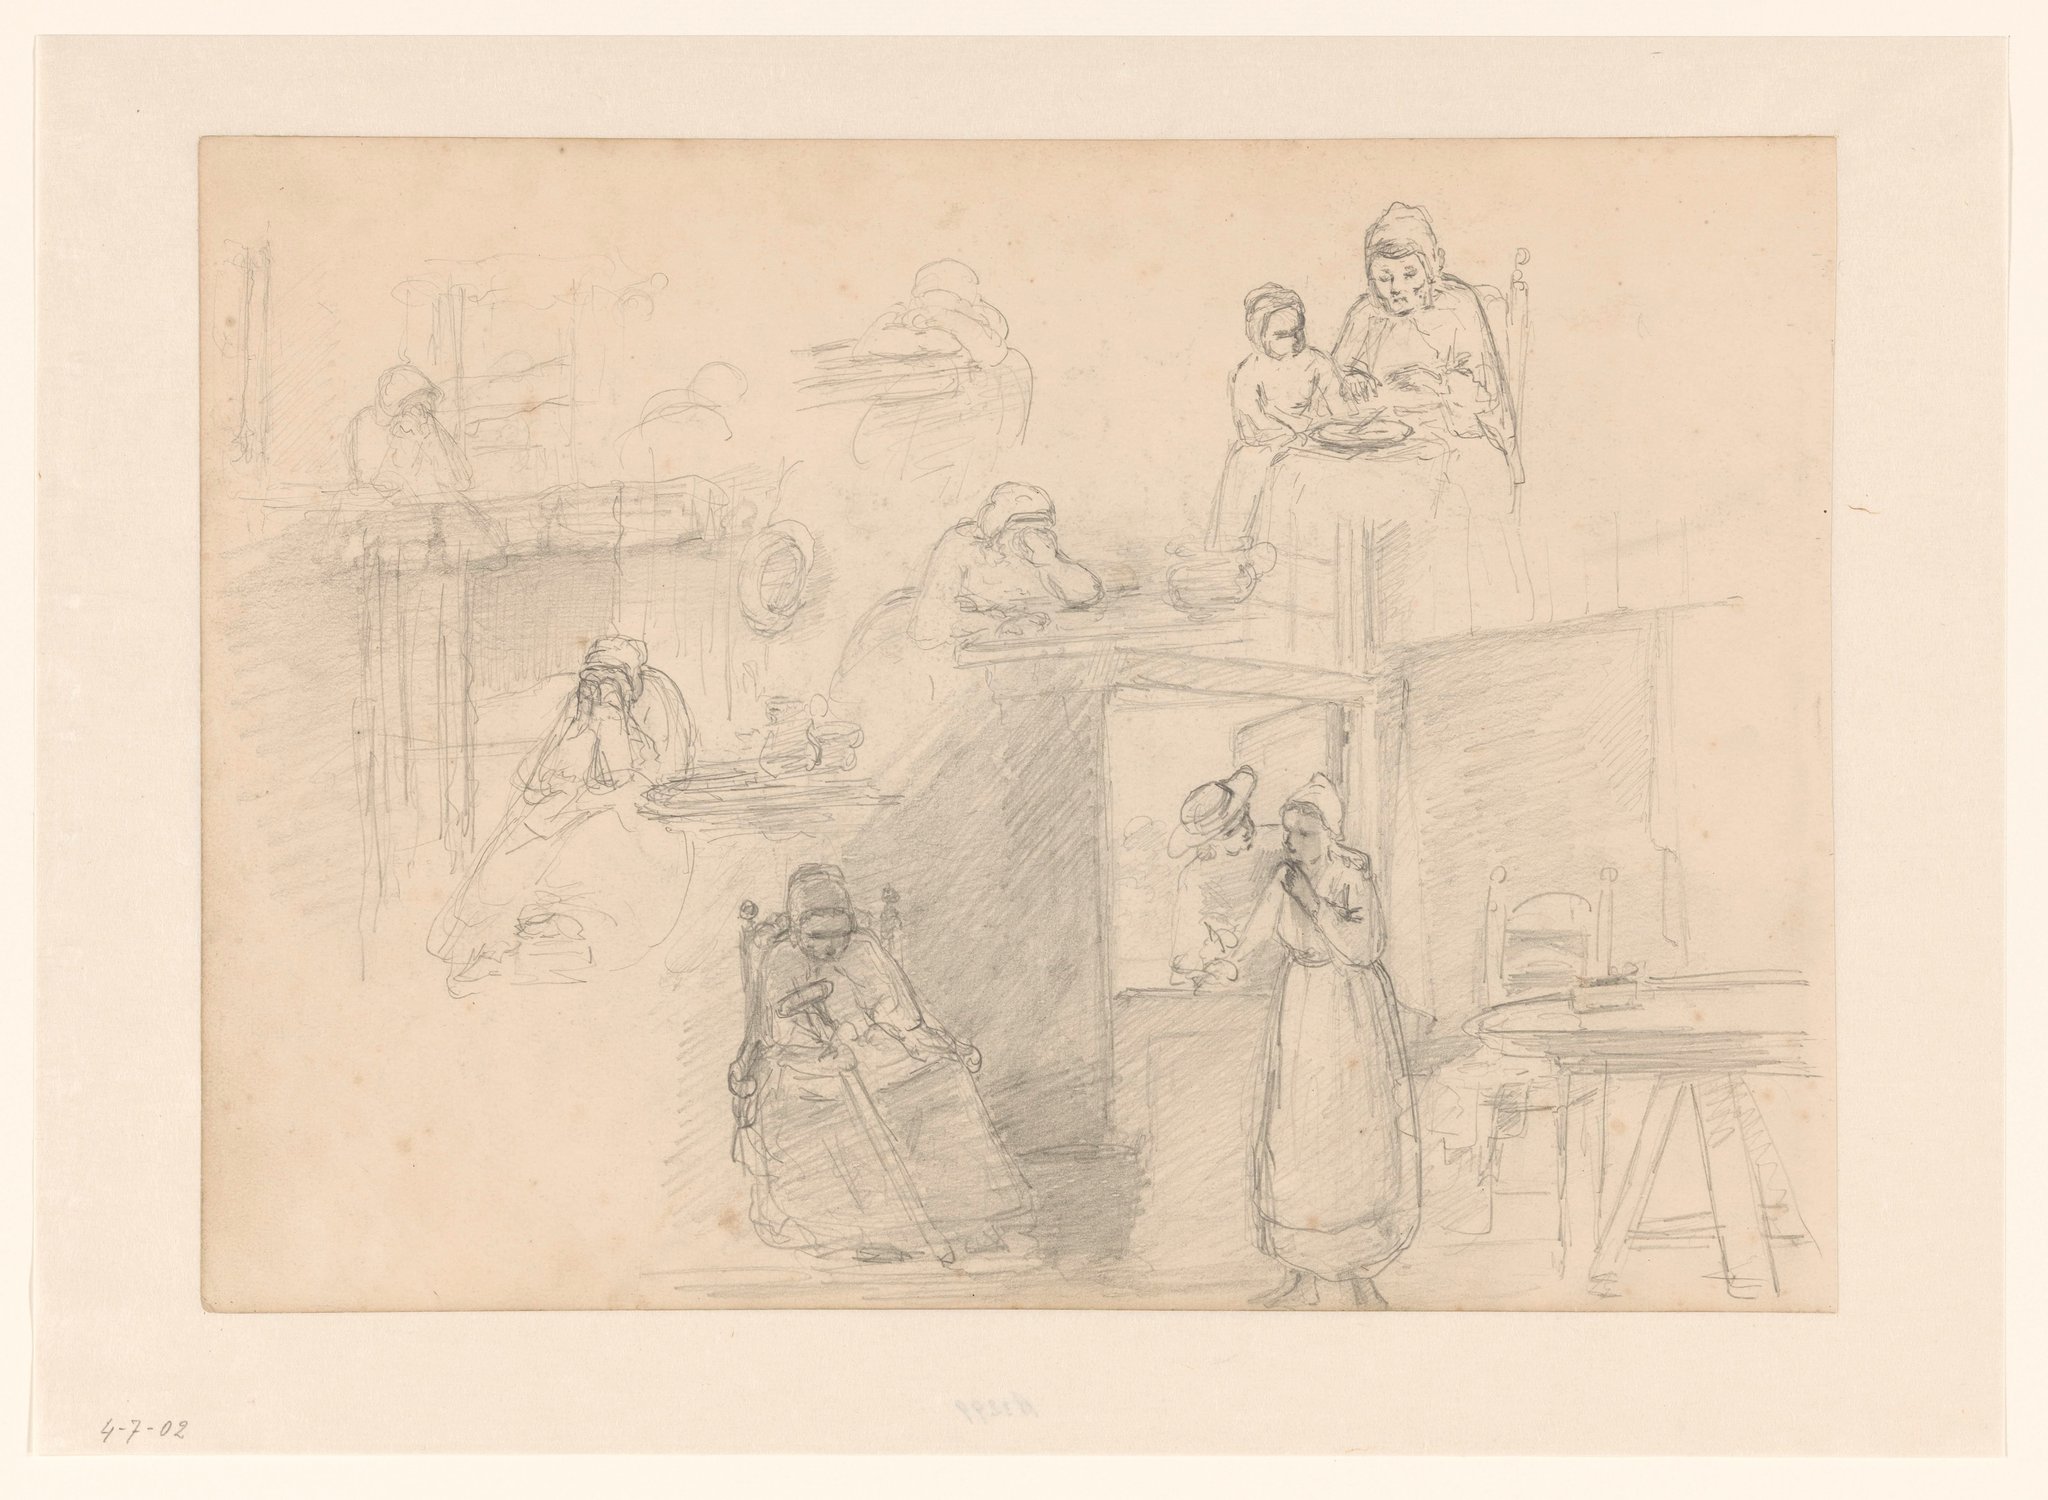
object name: drawing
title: Schetsblad met wenende oudjes en een meisje met haar vrijer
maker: hendrik valkenburg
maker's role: draughtsman, painter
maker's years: 1826-1896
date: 1836-1896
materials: paper, pencil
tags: family group, especially parents with their child(ren), (family) meal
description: Schetsblad met wenende oudjes en een meisje met haar vrijer bij een halfopen deur. Verso: tweemaal een melkmeisje met een kalf.